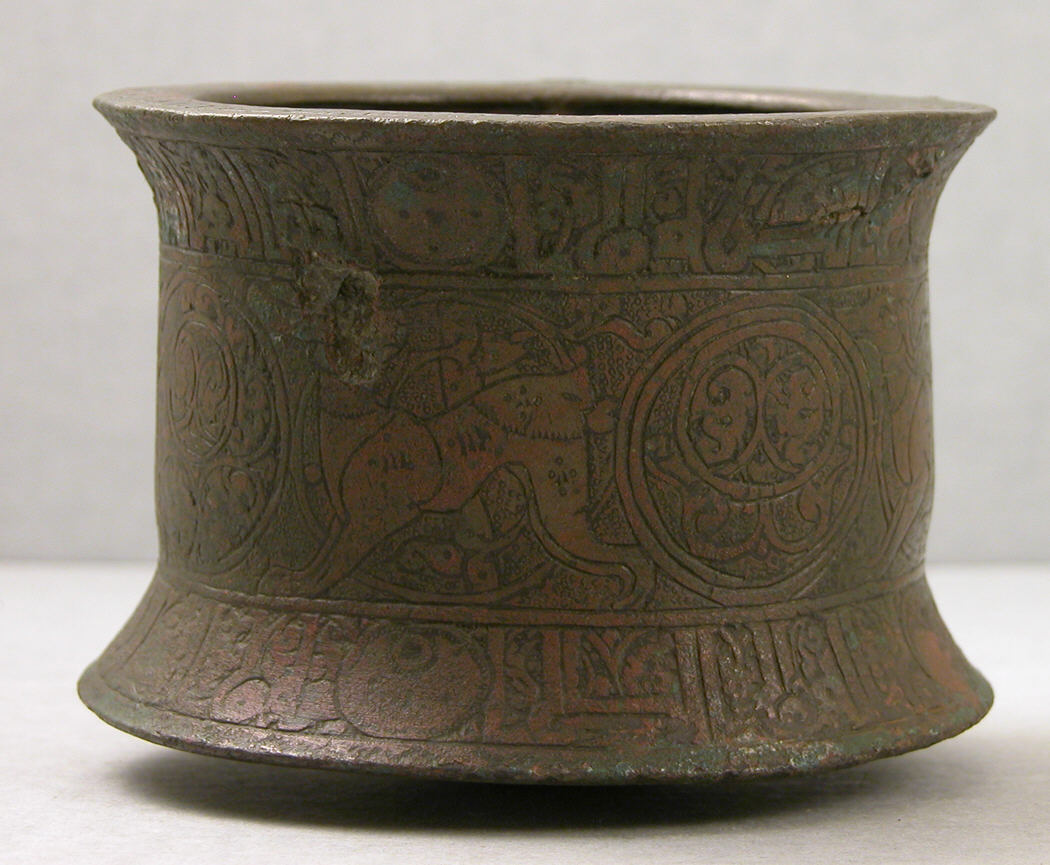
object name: mortar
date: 1101-1200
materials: bronze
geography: iran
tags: animals